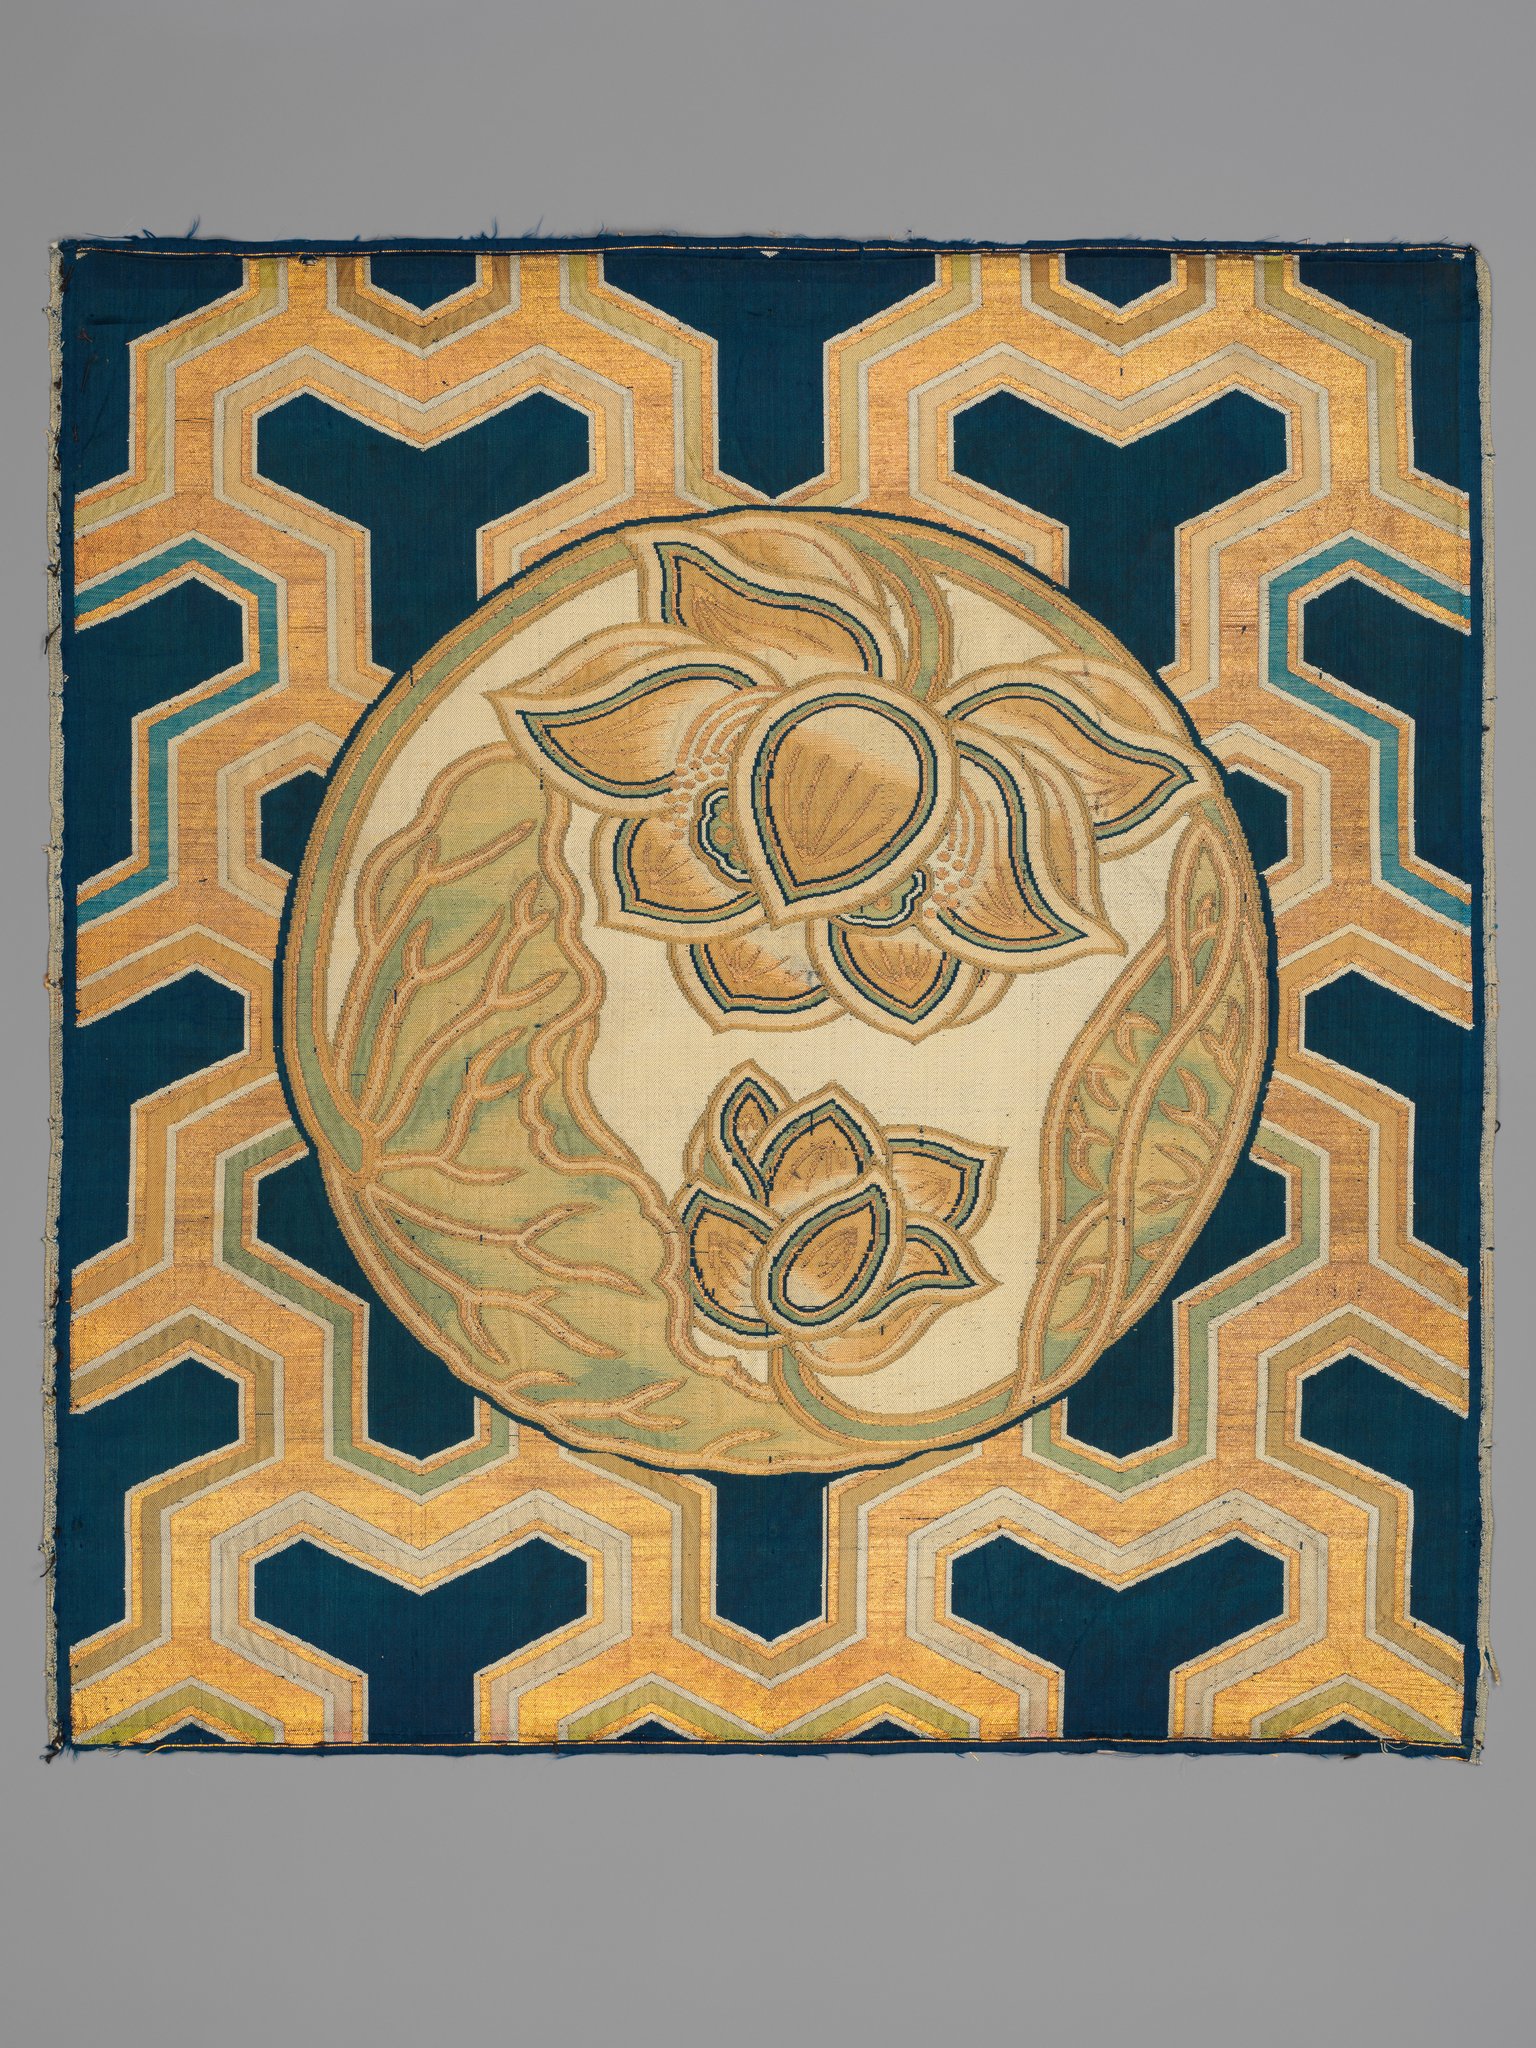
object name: square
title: Buddhist Altar Cloth (Uchishiki)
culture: japanese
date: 1801-1850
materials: silk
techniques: patterning, weave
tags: lotuses